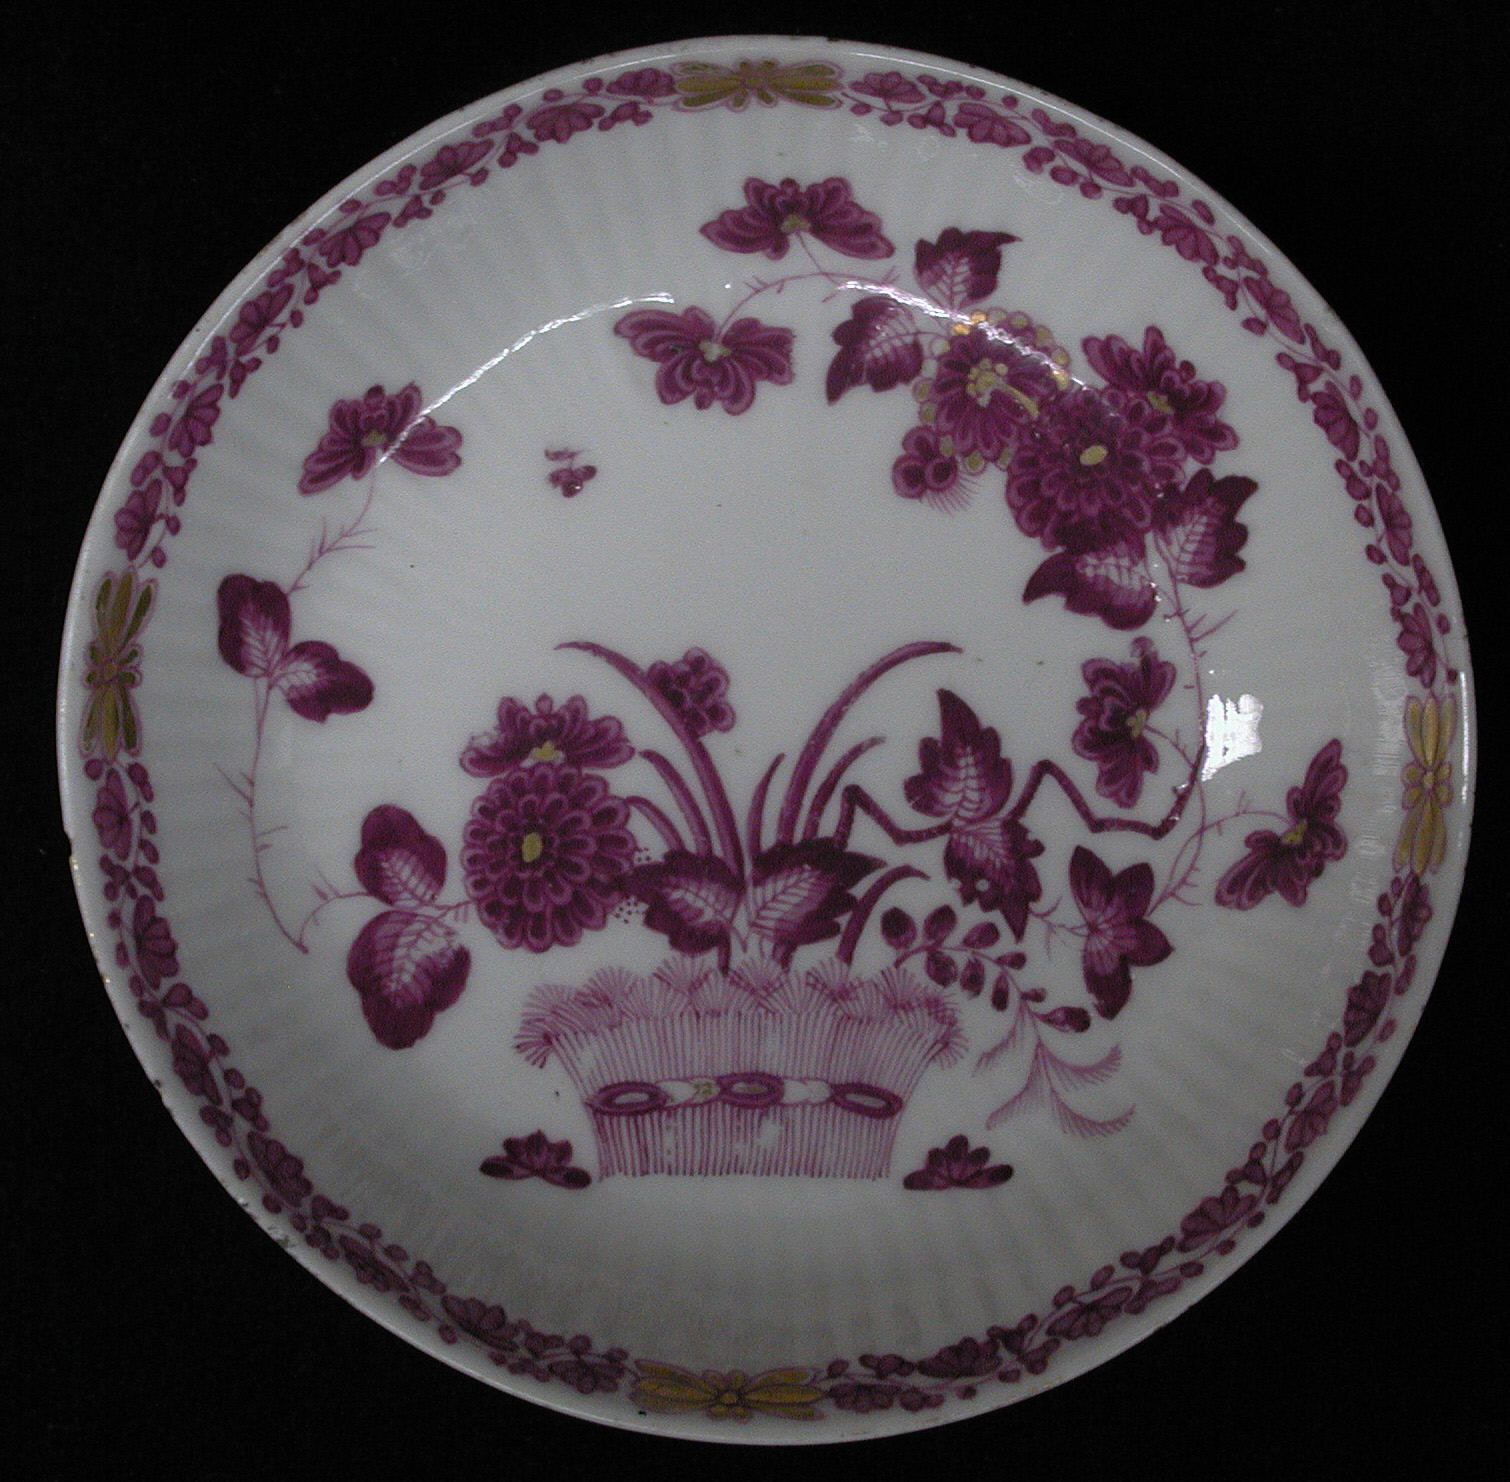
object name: saucer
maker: royal porcelain manufactory, berlin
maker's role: manufactory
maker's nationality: german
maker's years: 1763-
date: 1770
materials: hard paste porcelain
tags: flowers